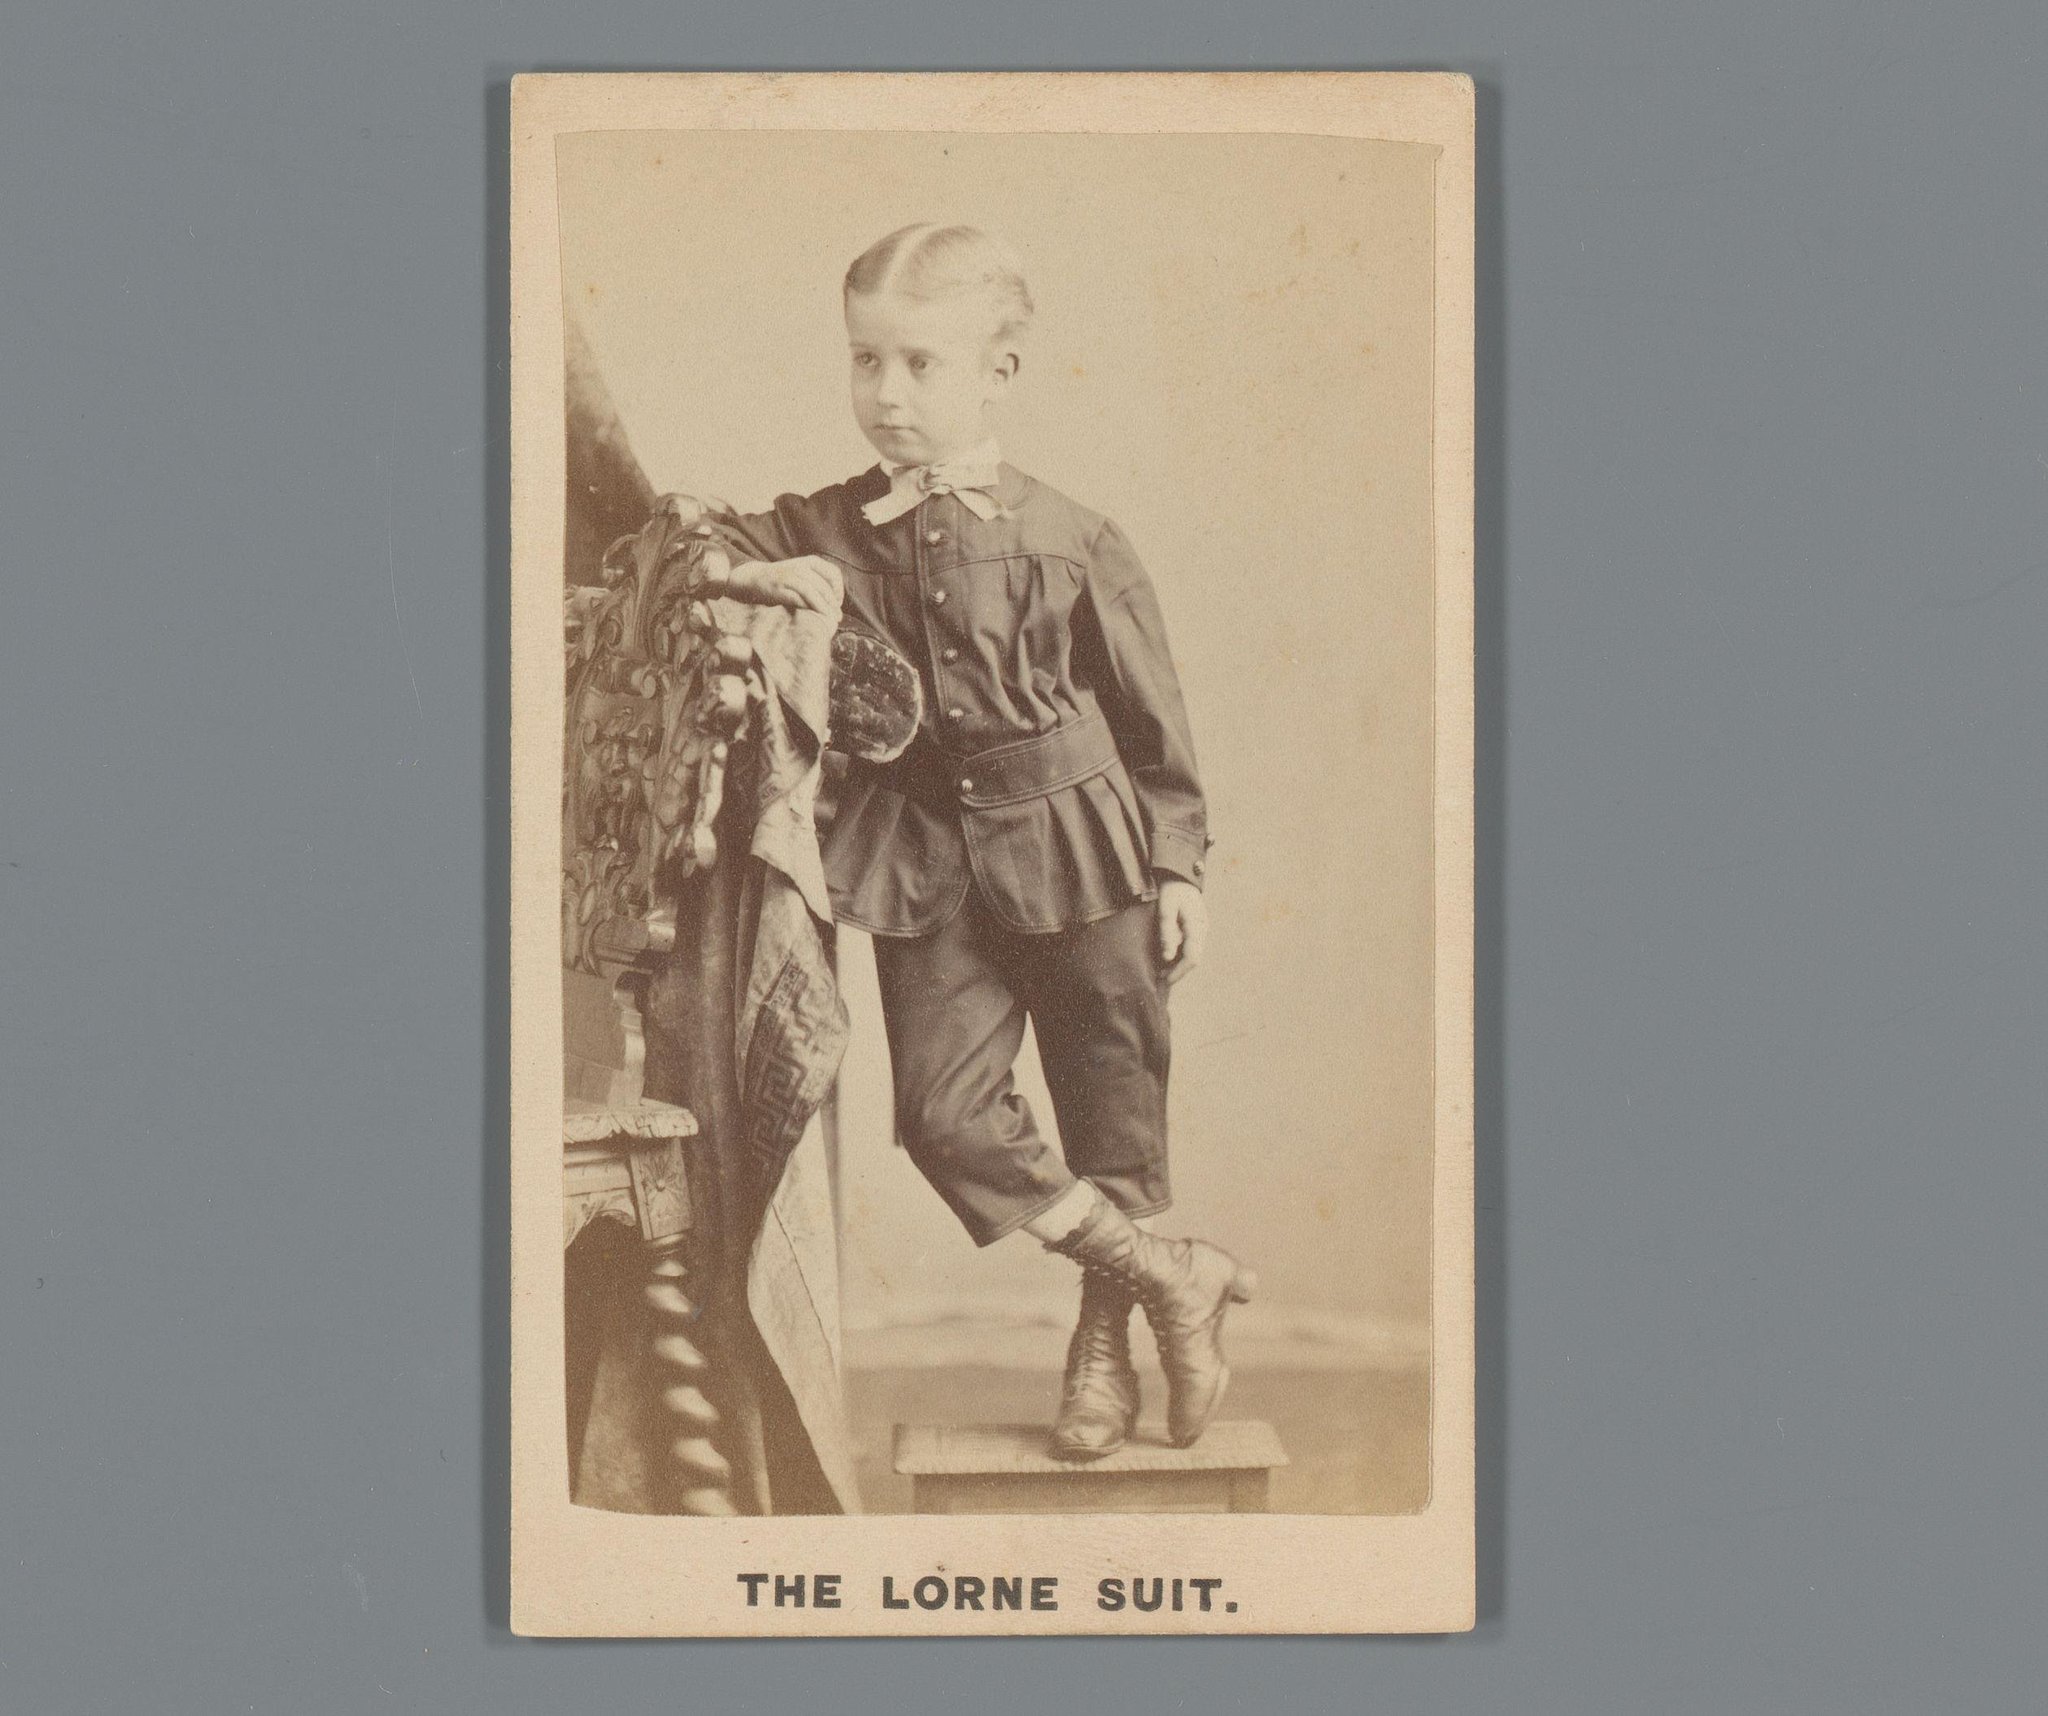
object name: photograph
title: The Lorne Suit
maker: napoleon sarony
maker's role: draughtsman, painter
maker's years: 1821-1896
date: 1871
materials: cardboard, photographic support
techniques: albumen print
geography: new york city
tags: advertising, ensemble of pieces of clothing: sailor suit, boy (child between toddler and youth), historical persons not known by name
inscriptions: inscription: ‘(...)/ PHOTOGRAPHED BY/ SARONY & CO.,/ 680 Broadway.’